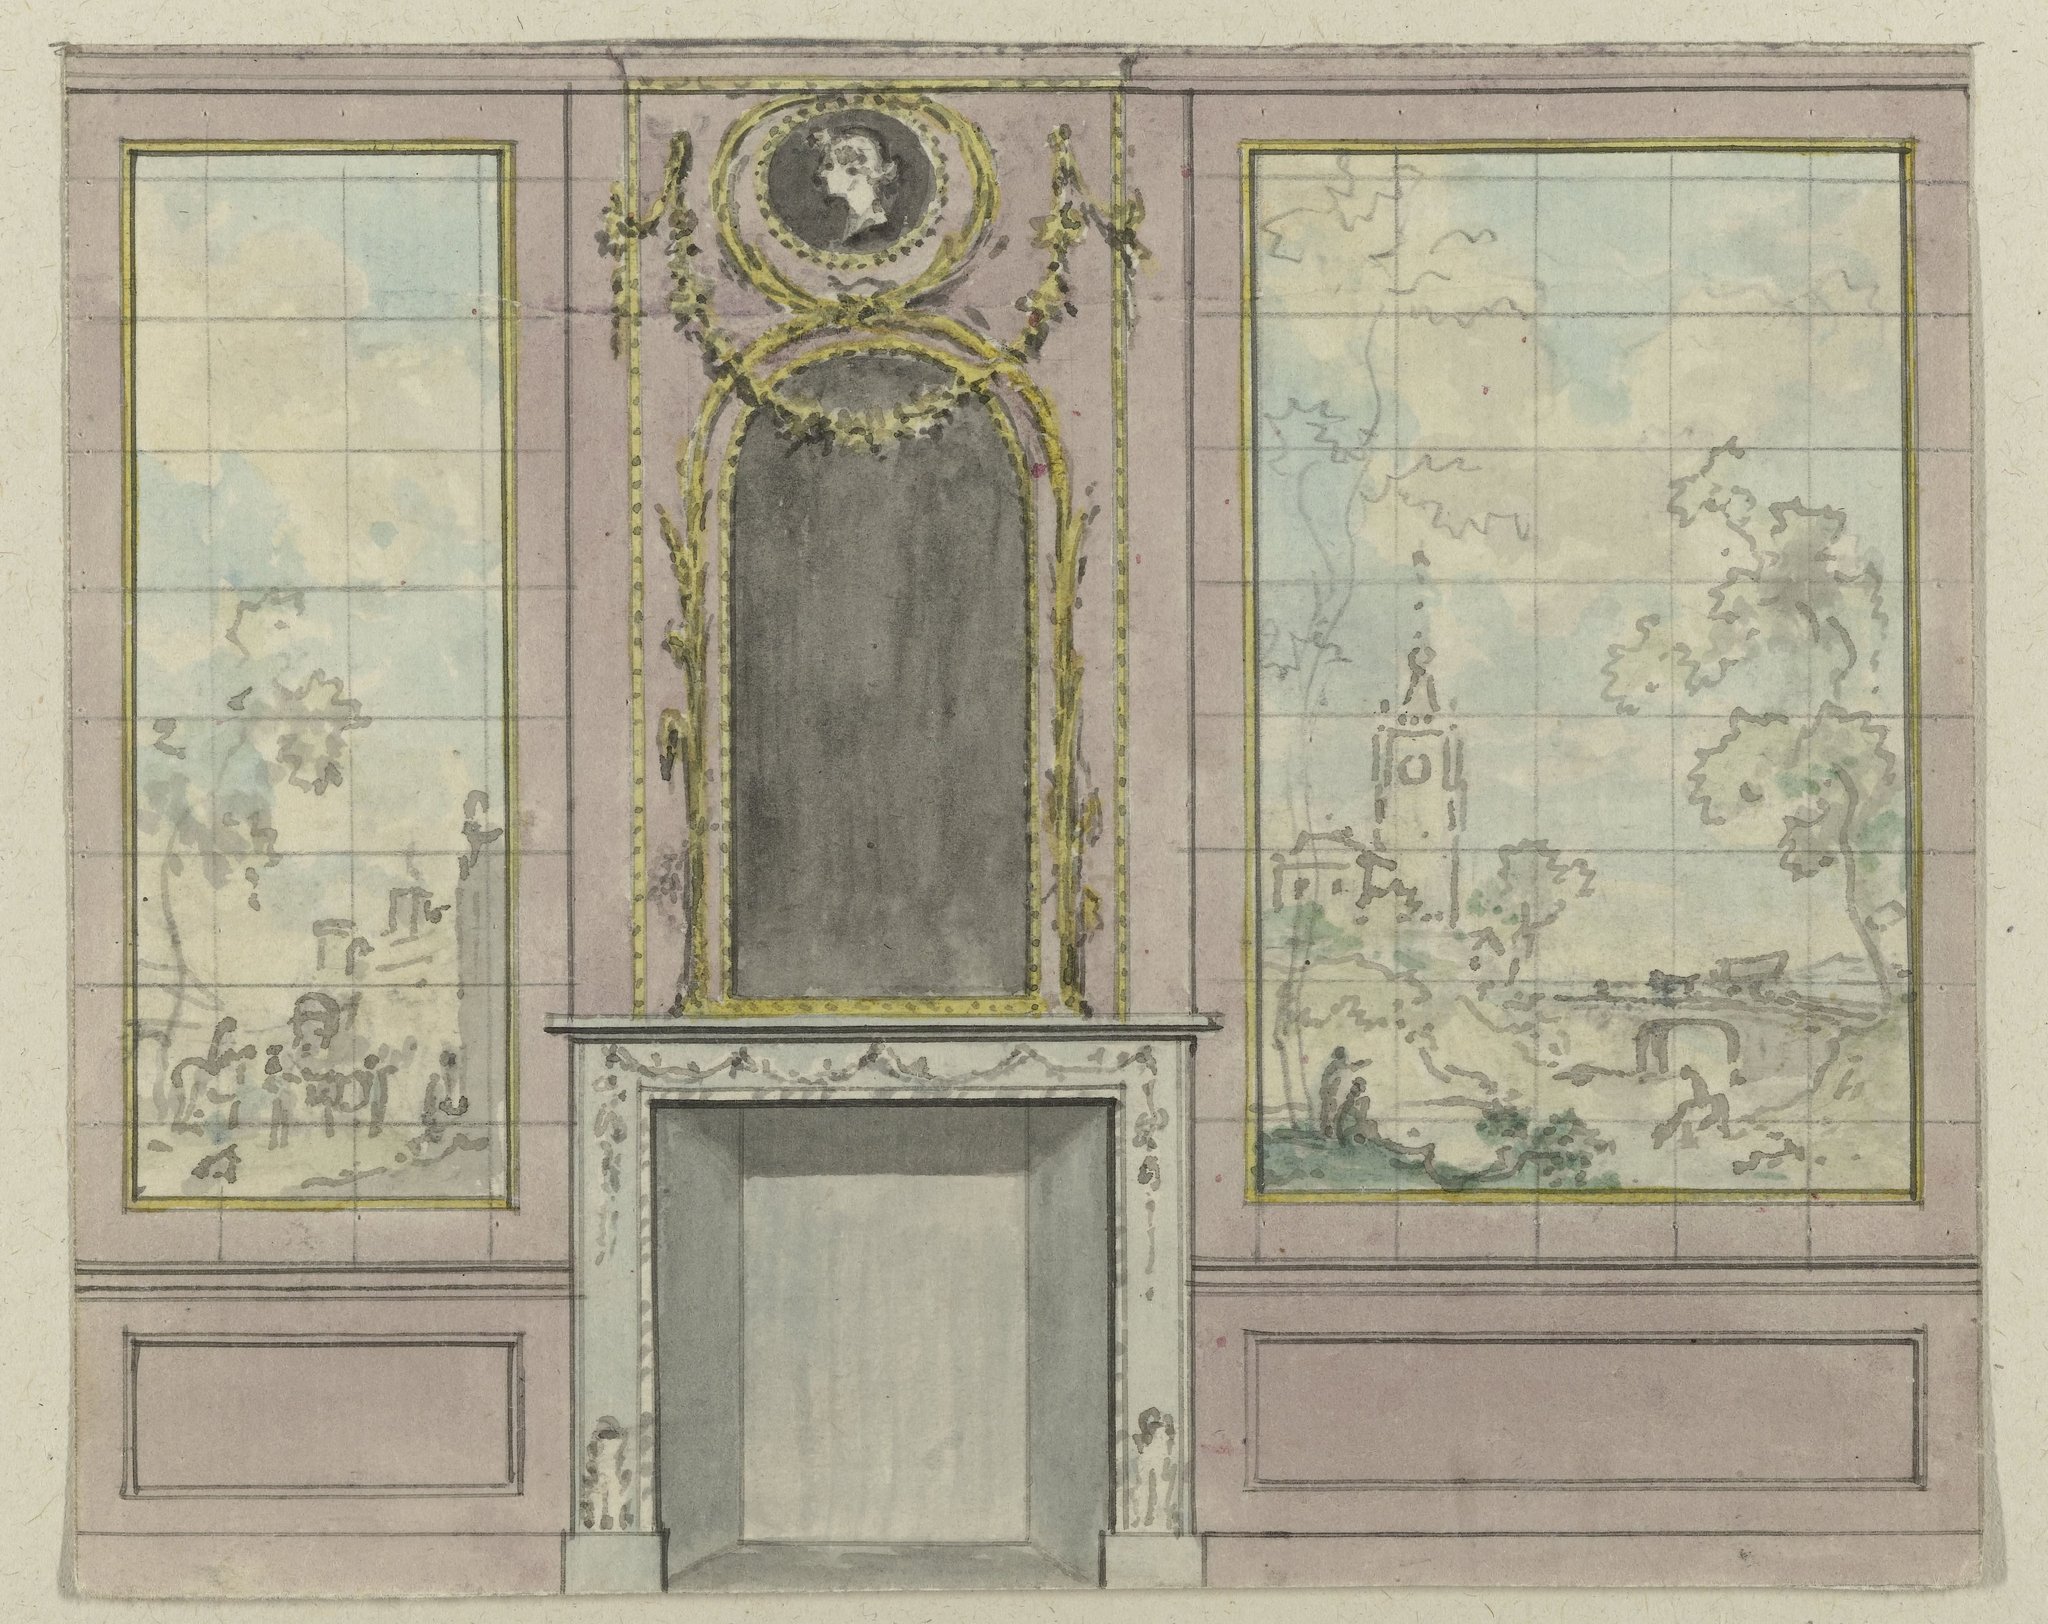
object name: drawing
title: Ontwerp voor een wandschildering voor Gerrit Duijm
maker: jurriaan andriessen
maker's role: draughtsman, painter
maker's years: 1742-1819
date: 1783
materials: ink, paper, pencil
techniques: brush, pen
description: Wand met twee behangselvakken ter weerszijden van een schoorsteen.